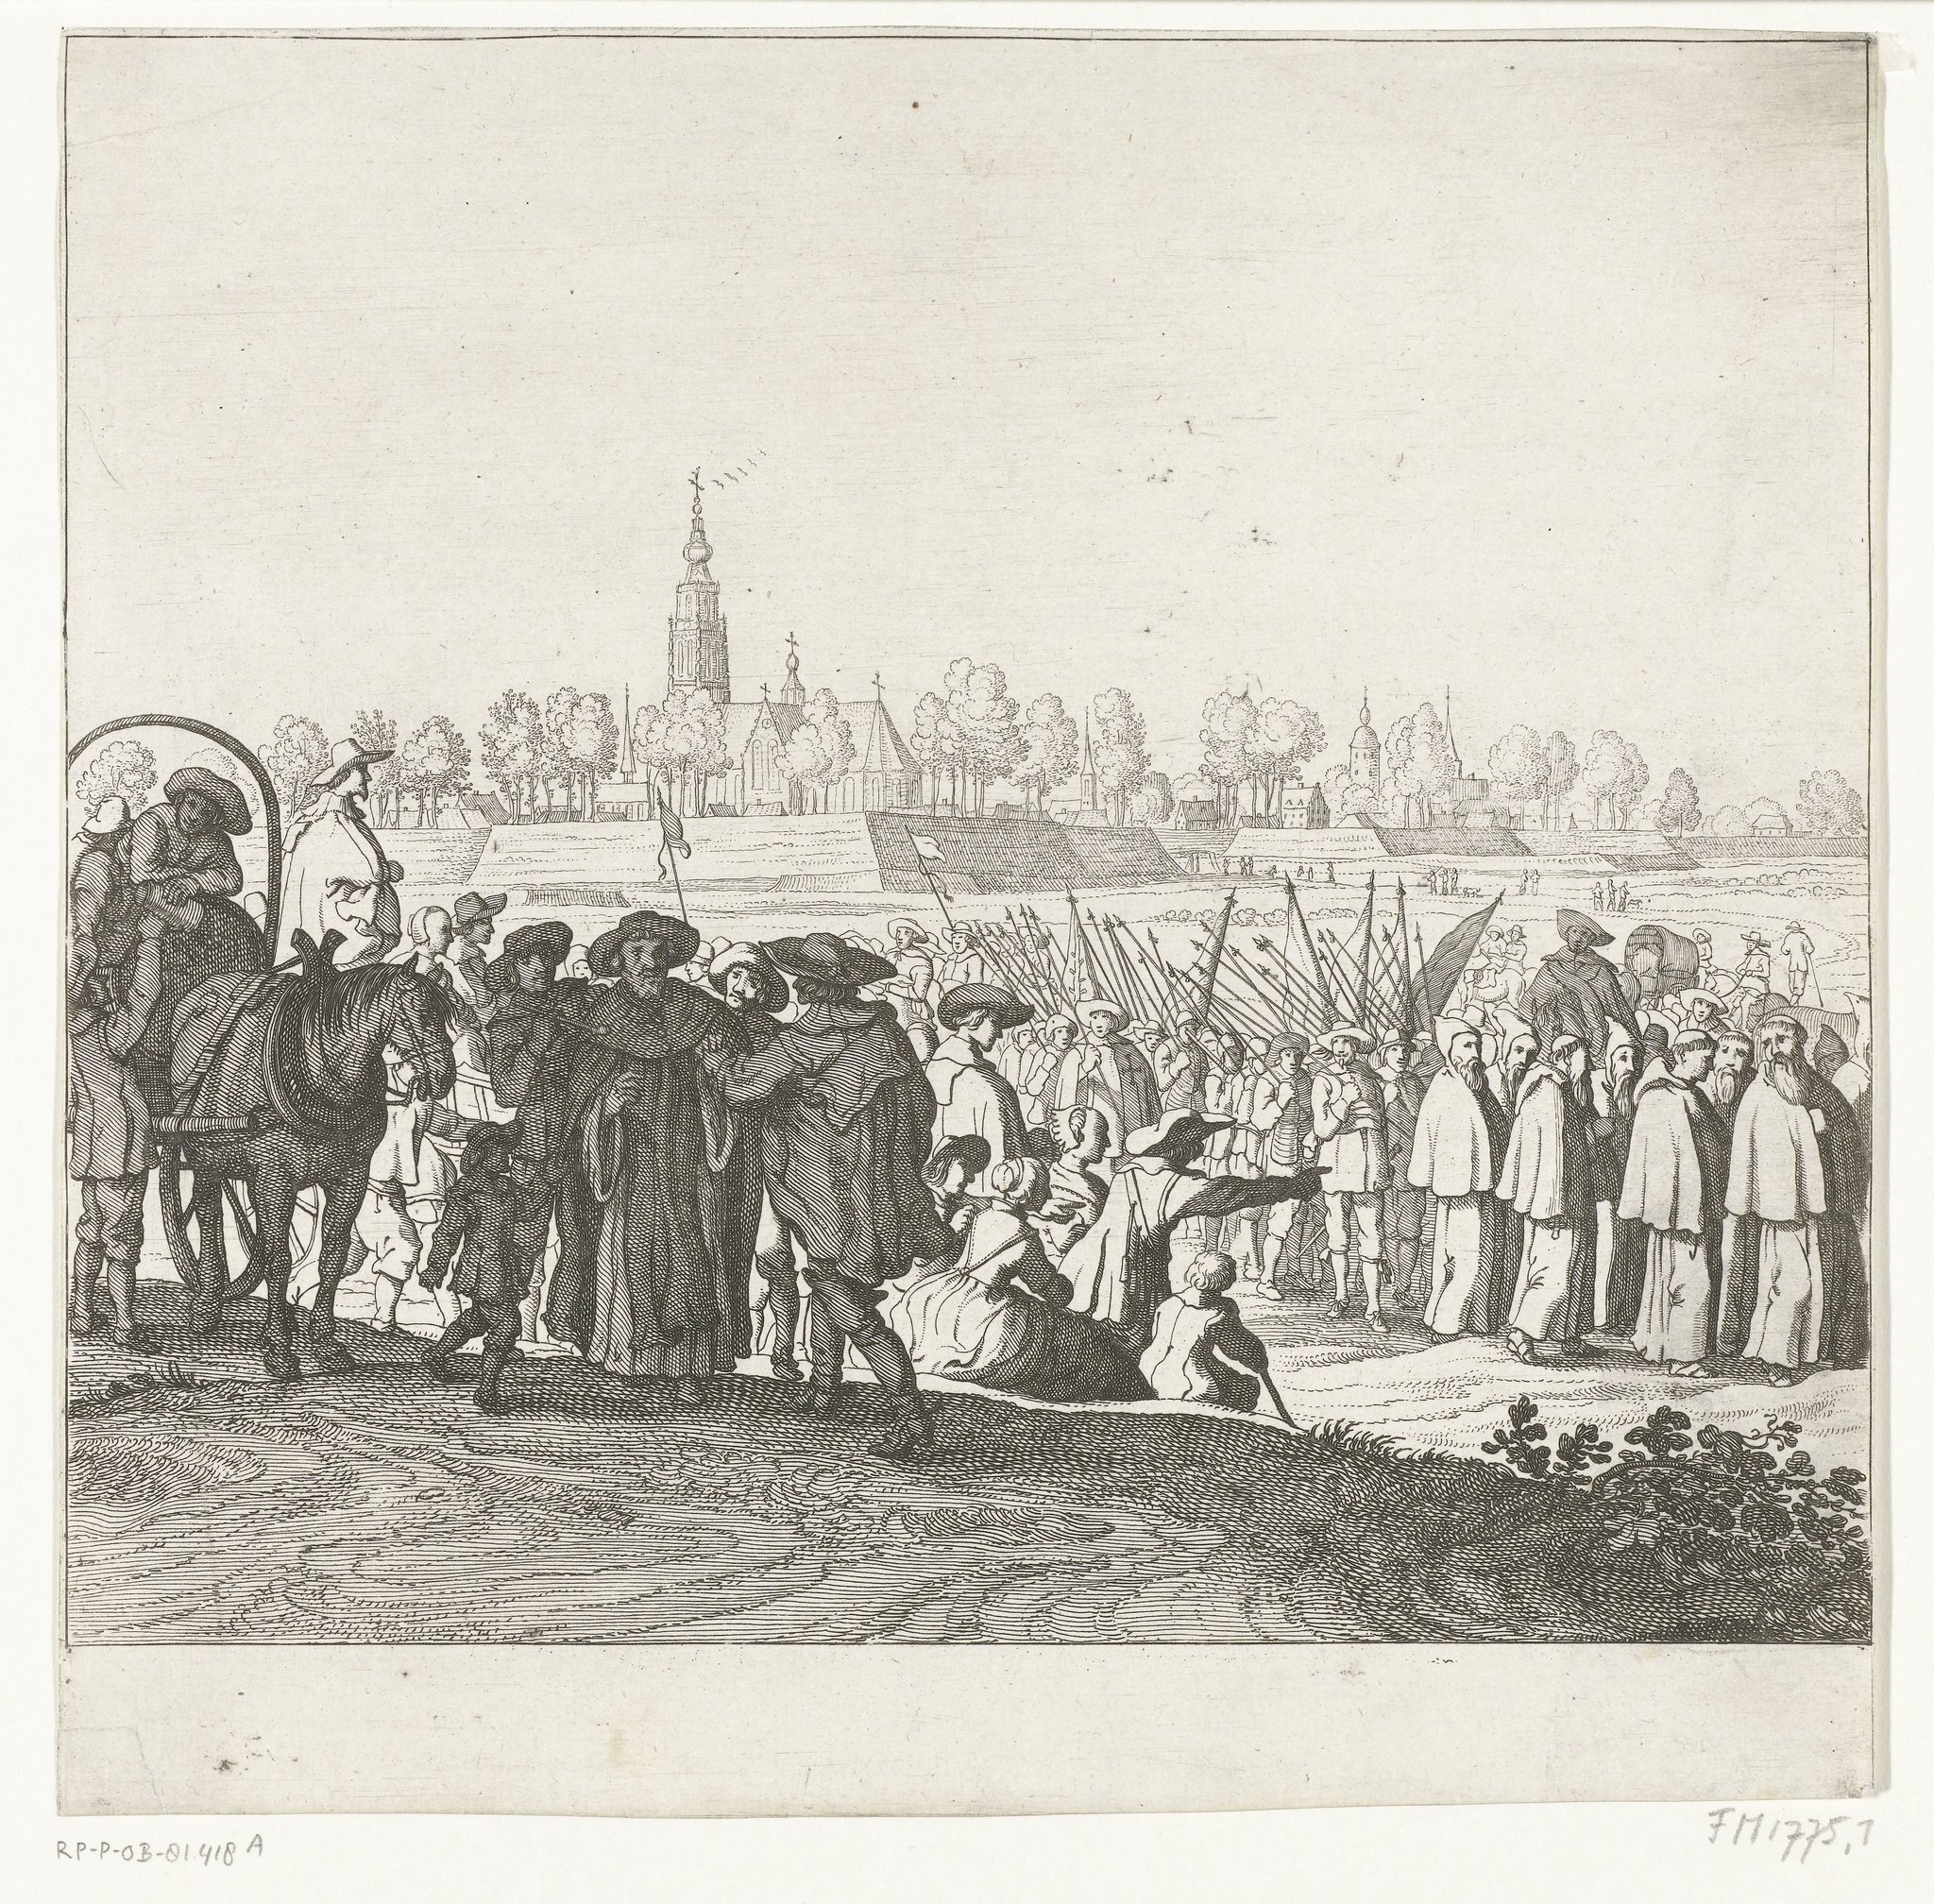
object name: print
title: Uittocht van het Spaanse garnizoen uit Breda (plaat 1), 1637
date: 1637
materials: paper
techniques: etching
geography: northern netherlands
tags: frederick henry (prince of orange), retreat of the defeated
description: De uittocht van het Spaanse garnizoen uit Breda na de verovering door het Staatse leger onder Frederik Hendrik, 10 oktober 1637. Eerste blad uit een ongemonteerd ensemble van vier bladen (waarvan slechts drie aanwezig). De stoet trekt voorbij aan de toeschouwers, op de achtergrond het profiel van de stad. In de stoet monniken en soldaten.